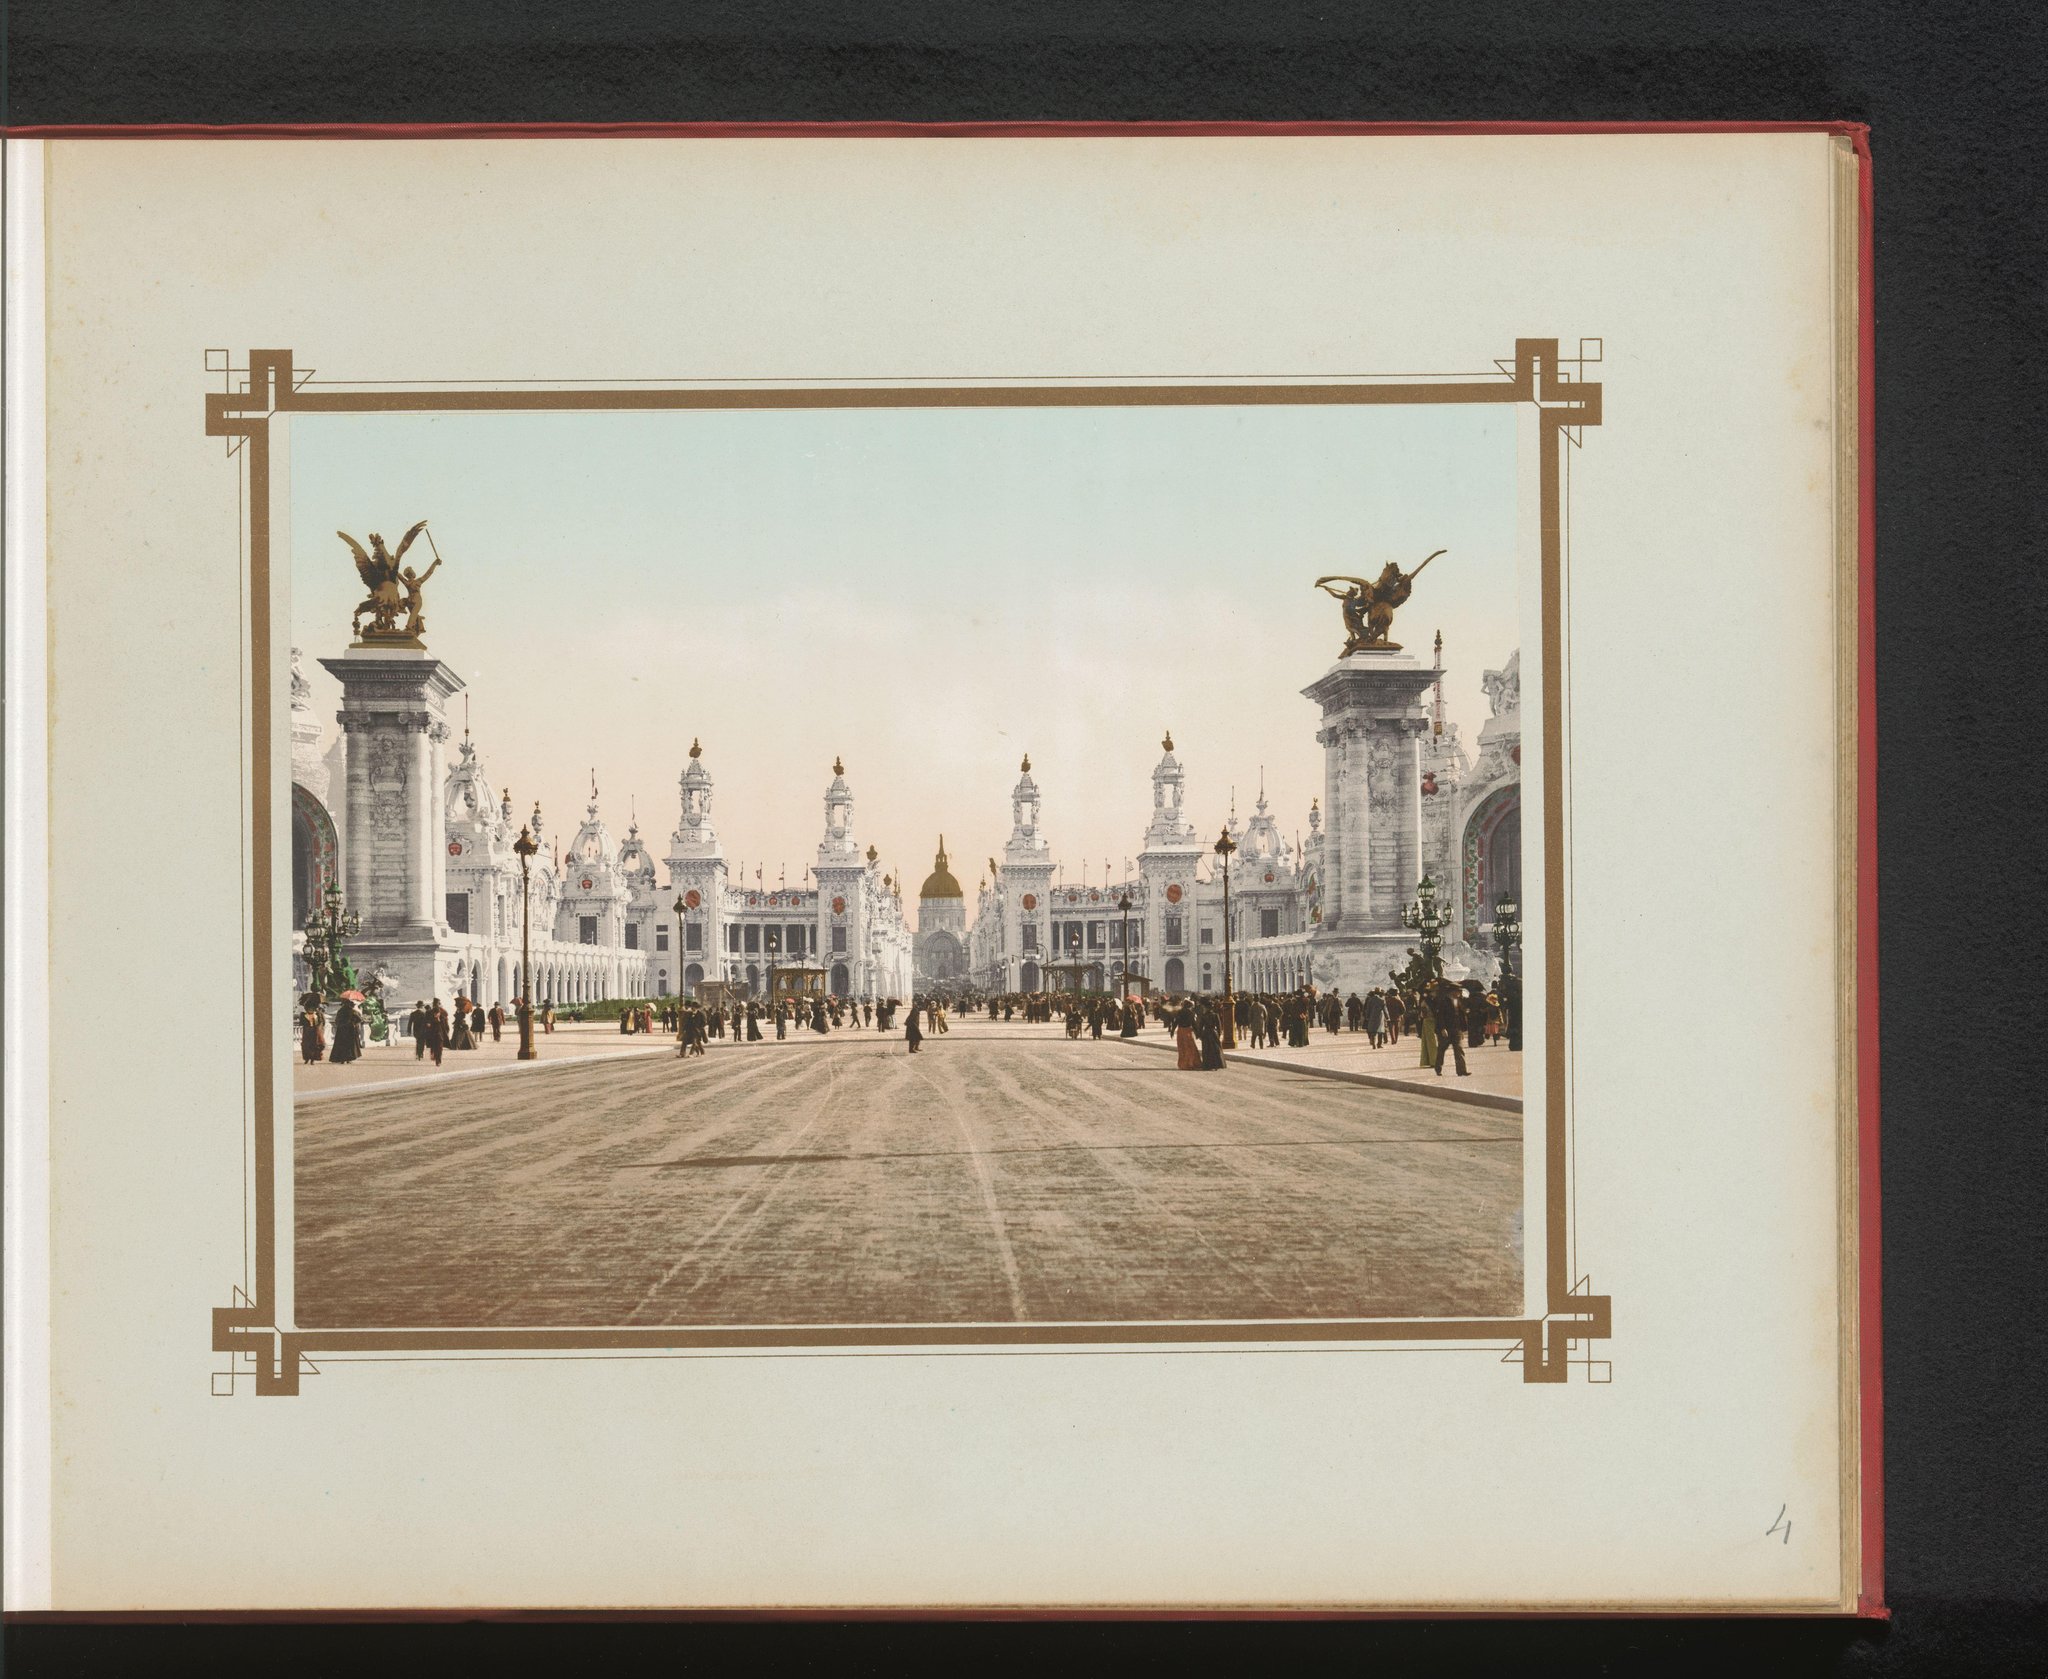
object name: photomechanical print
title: Gezicht op Avenue Nicolas II tijdens de Wereldtentoonstelling van 1900 te Parijs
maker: Anonymous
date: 1900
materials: paper, photographic process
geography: paris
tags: world fair, world exhibition, avenue, boulevard, promenade, esplanade, paris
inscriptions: inscription: ‘17309. P.Z. Paris, Avenue Nicolas II/ Vers le dome des invals’